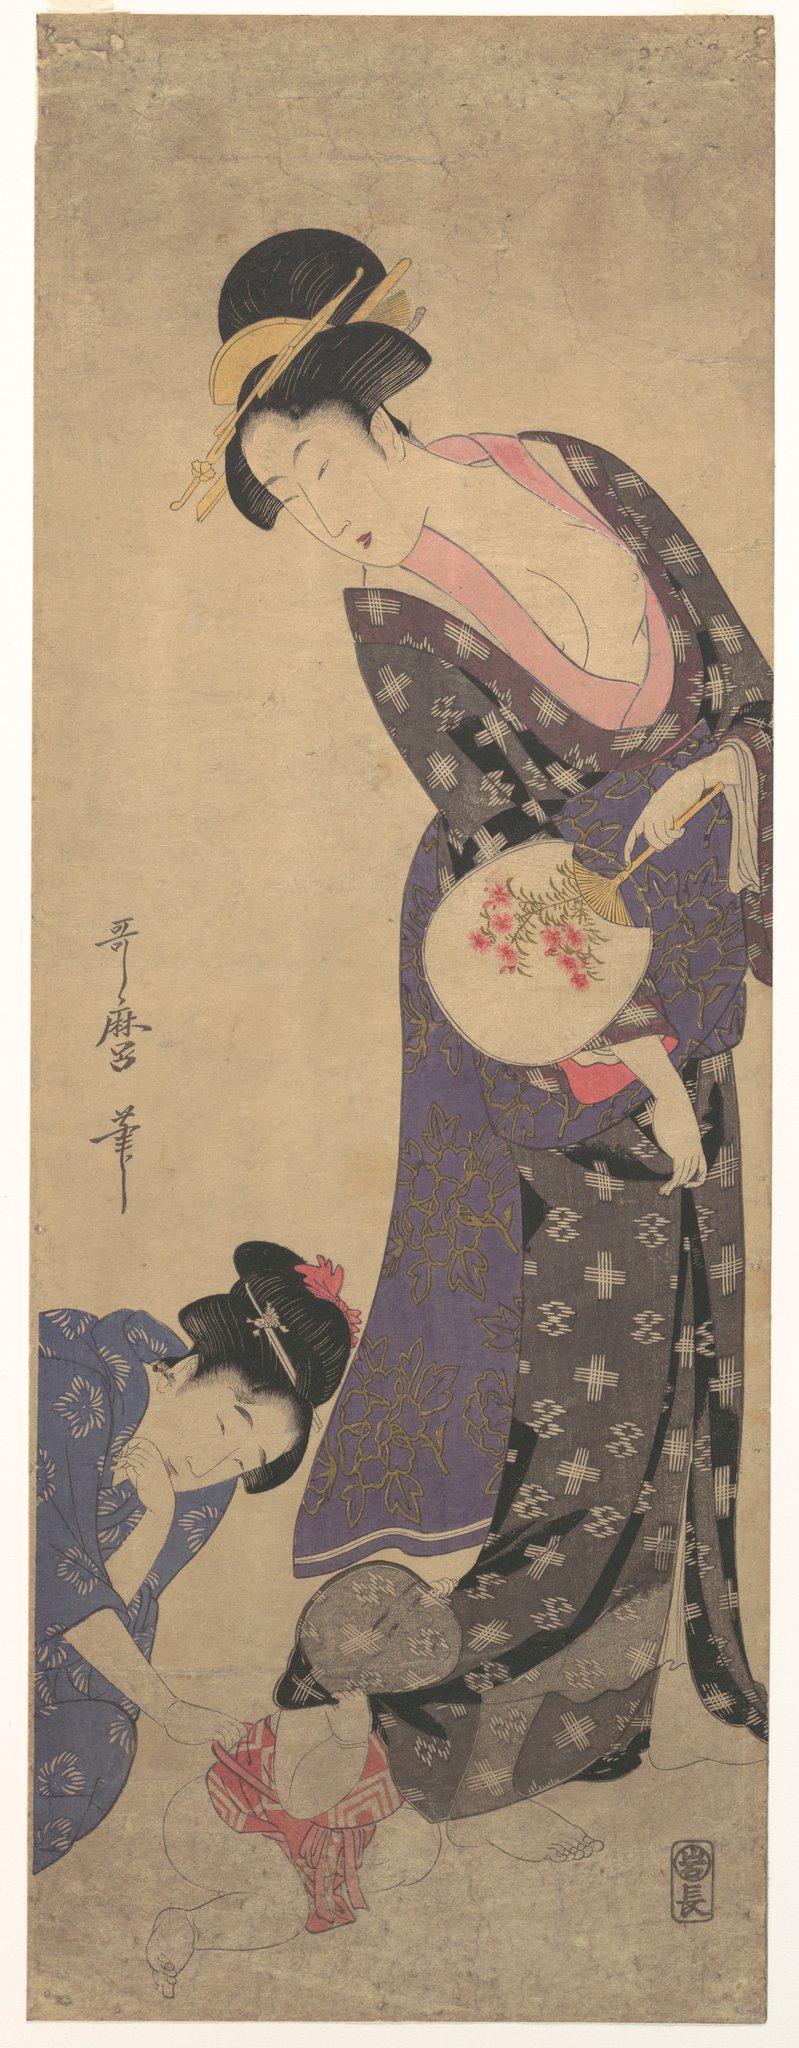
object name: print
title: Two Women with a Baby who is Playing on the Floor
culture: japanese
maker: kitagawa utamaro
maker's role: artist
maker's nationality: japanese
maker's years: 1754-1806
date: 1793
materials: ink, paper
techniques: woodblock print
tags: fans,infants,mothers,women